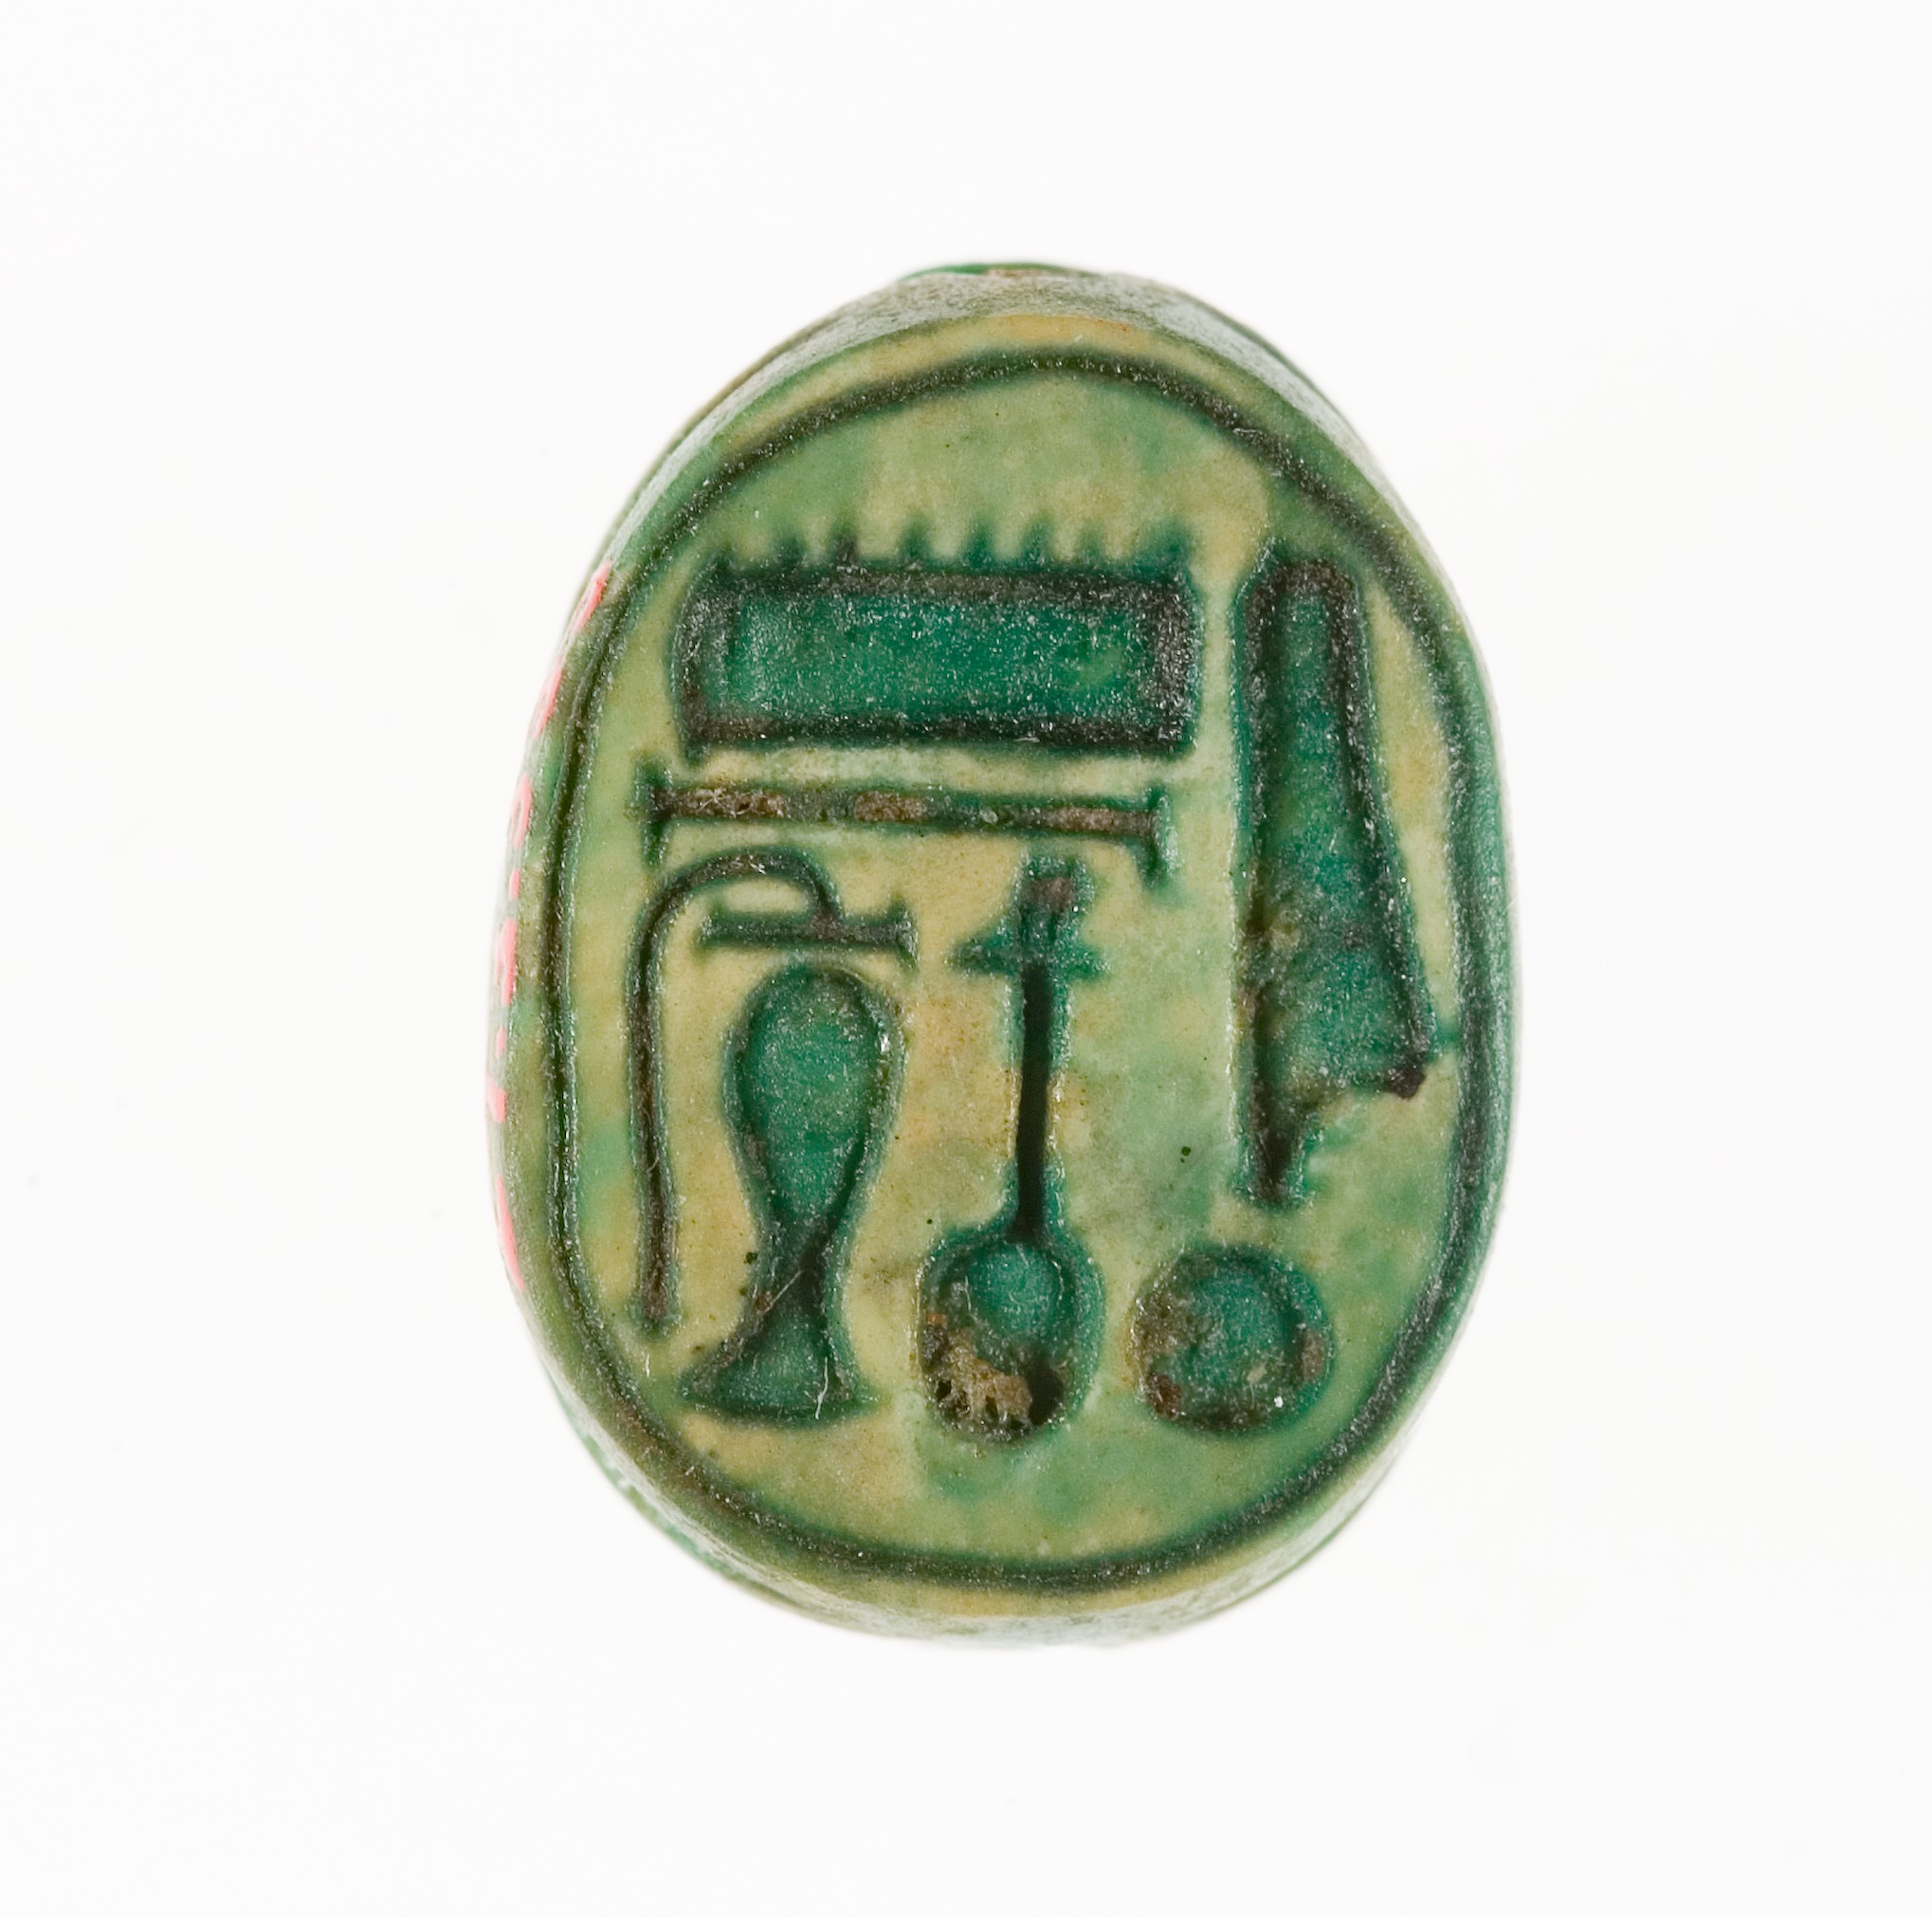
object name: scarab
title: Scarab Inscribed with the Name of the God Amun-Re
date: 1479-1458 BCE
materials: stone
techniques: glazing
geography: egypt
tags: scarabs